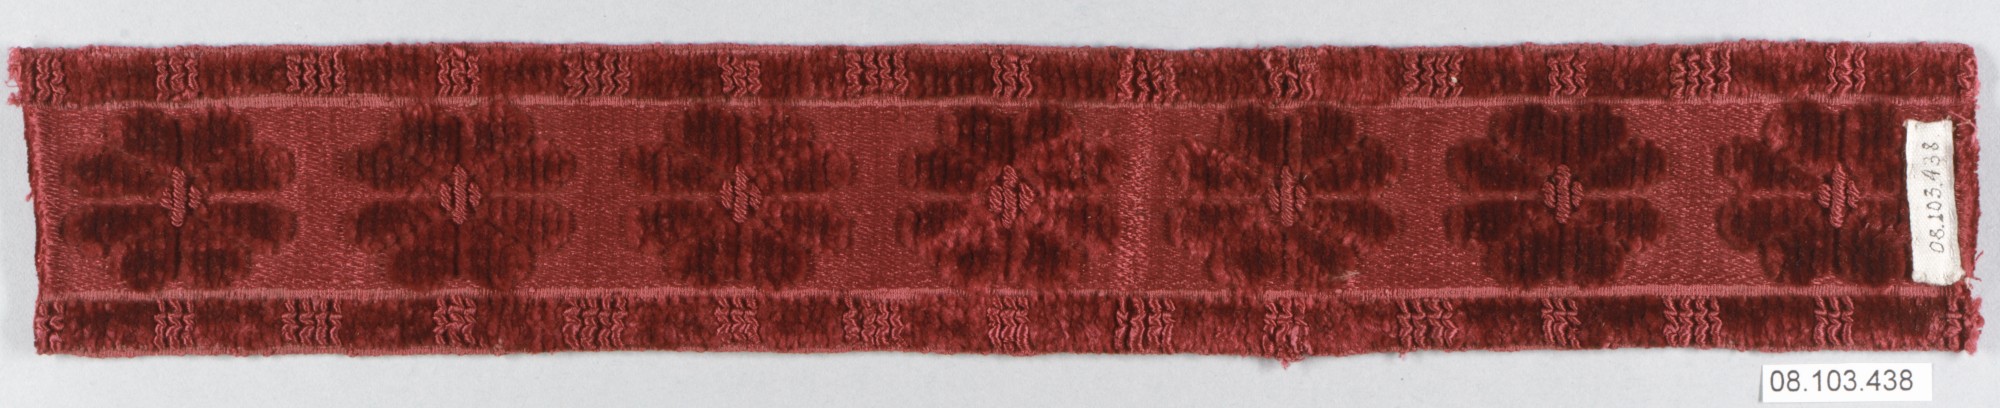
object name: galloon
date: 1801-1833